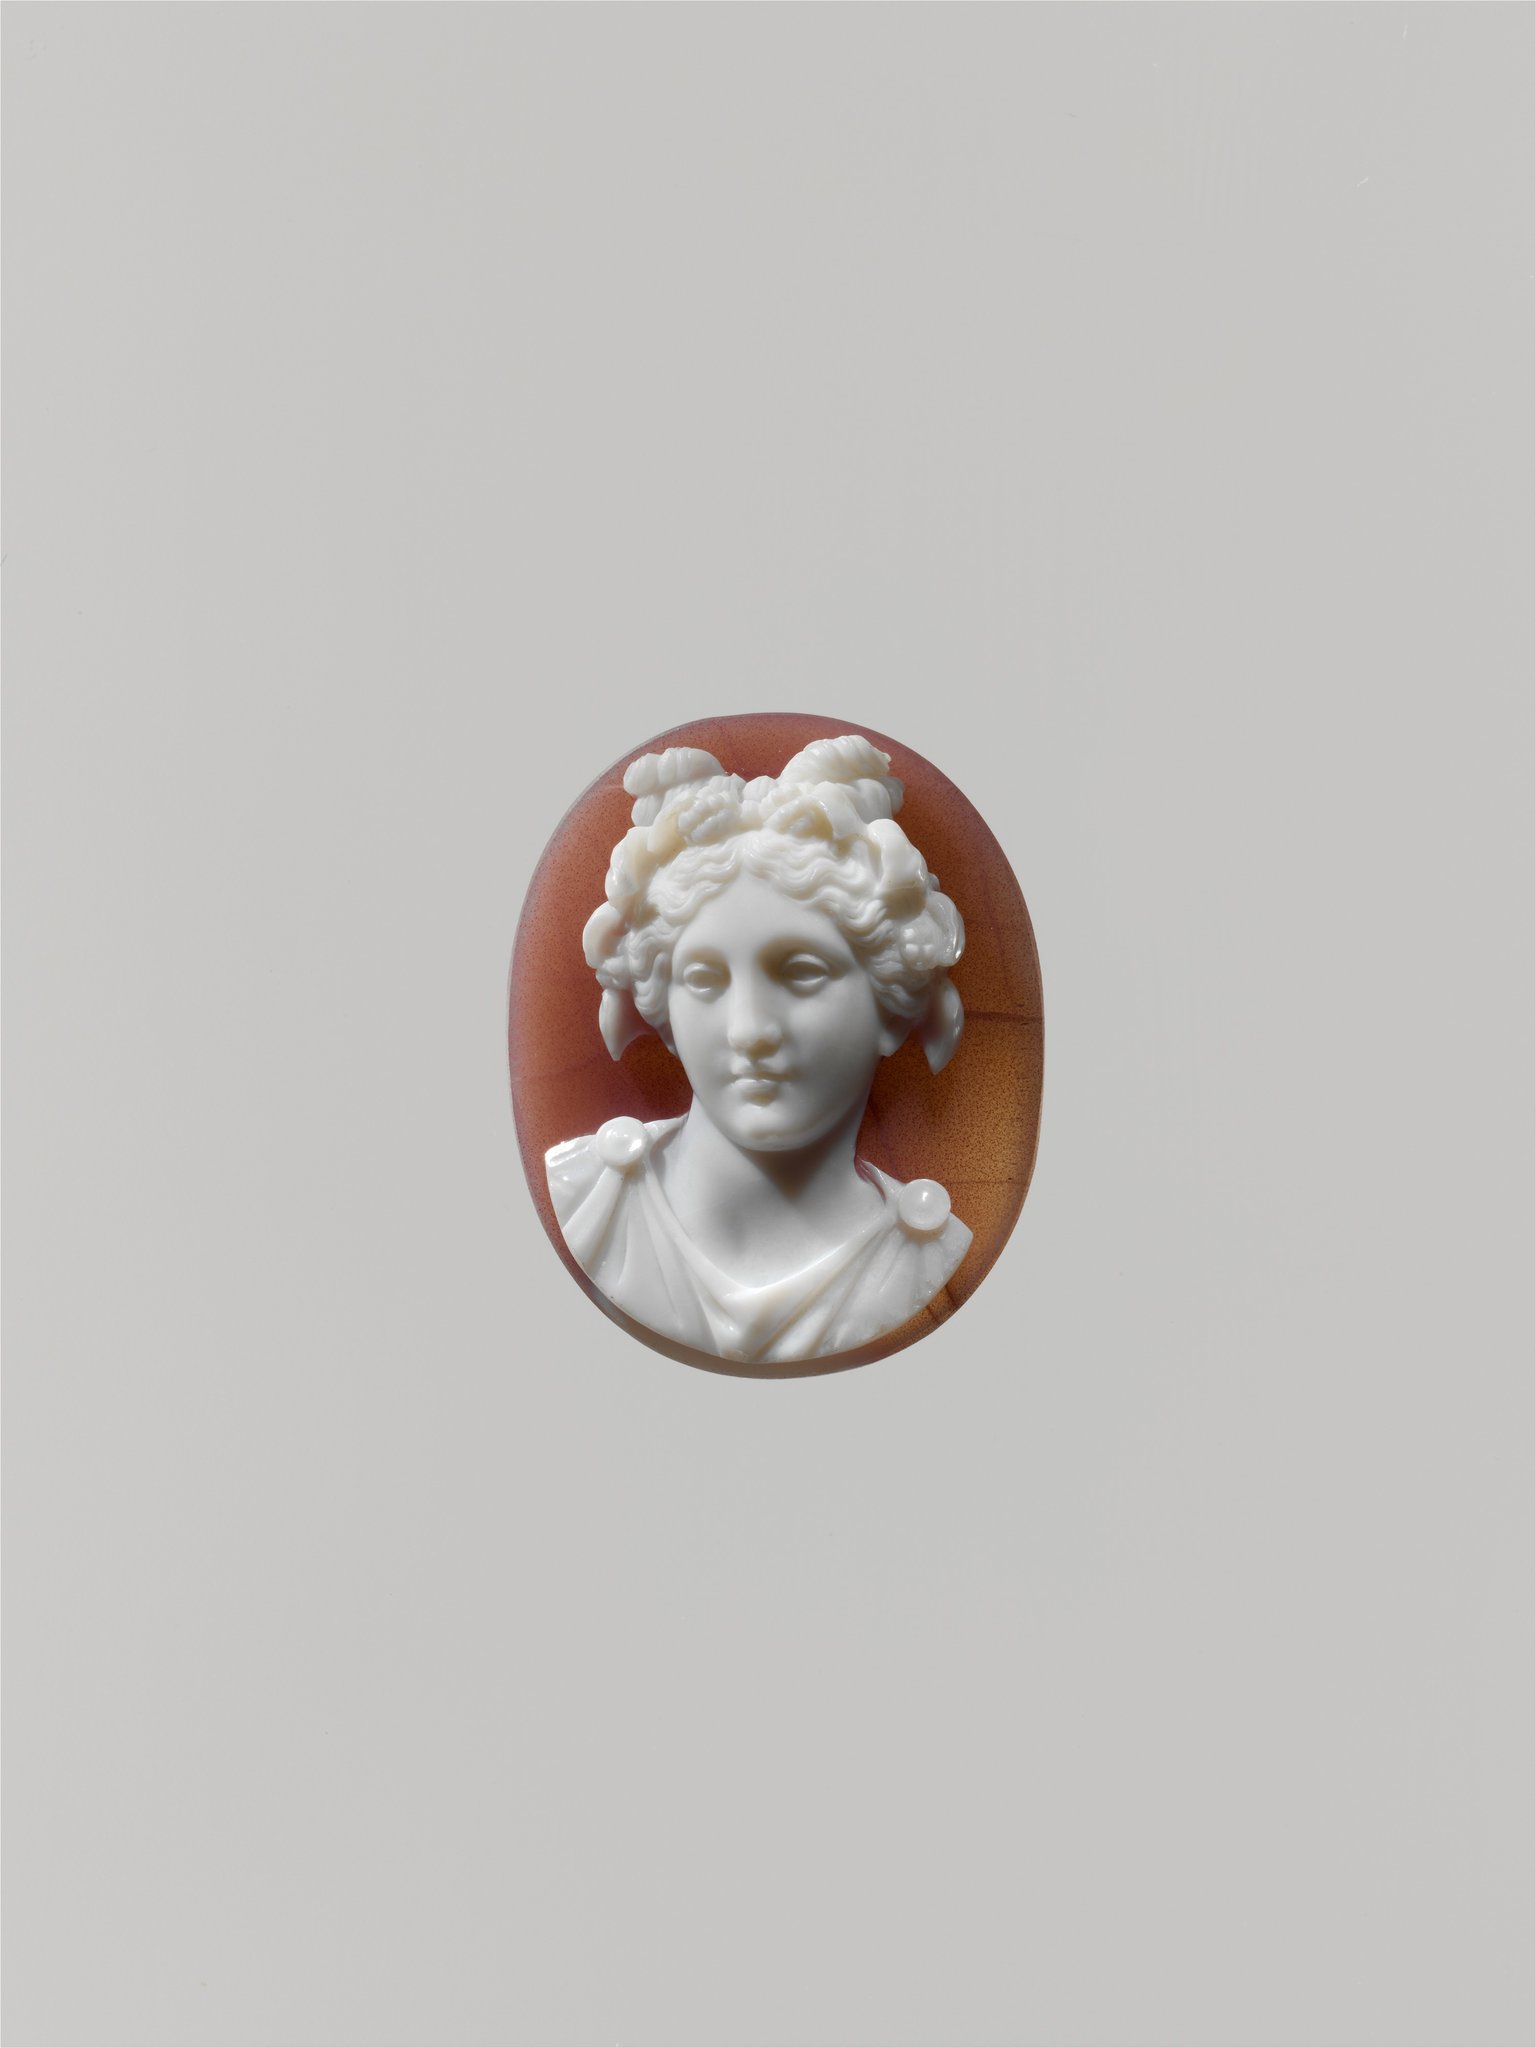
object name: cameo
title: Thalia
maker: giuseppe girometti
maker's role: artist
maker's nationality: italian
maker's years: 1780-1851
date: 1826-1850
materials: onyx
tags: women,muses